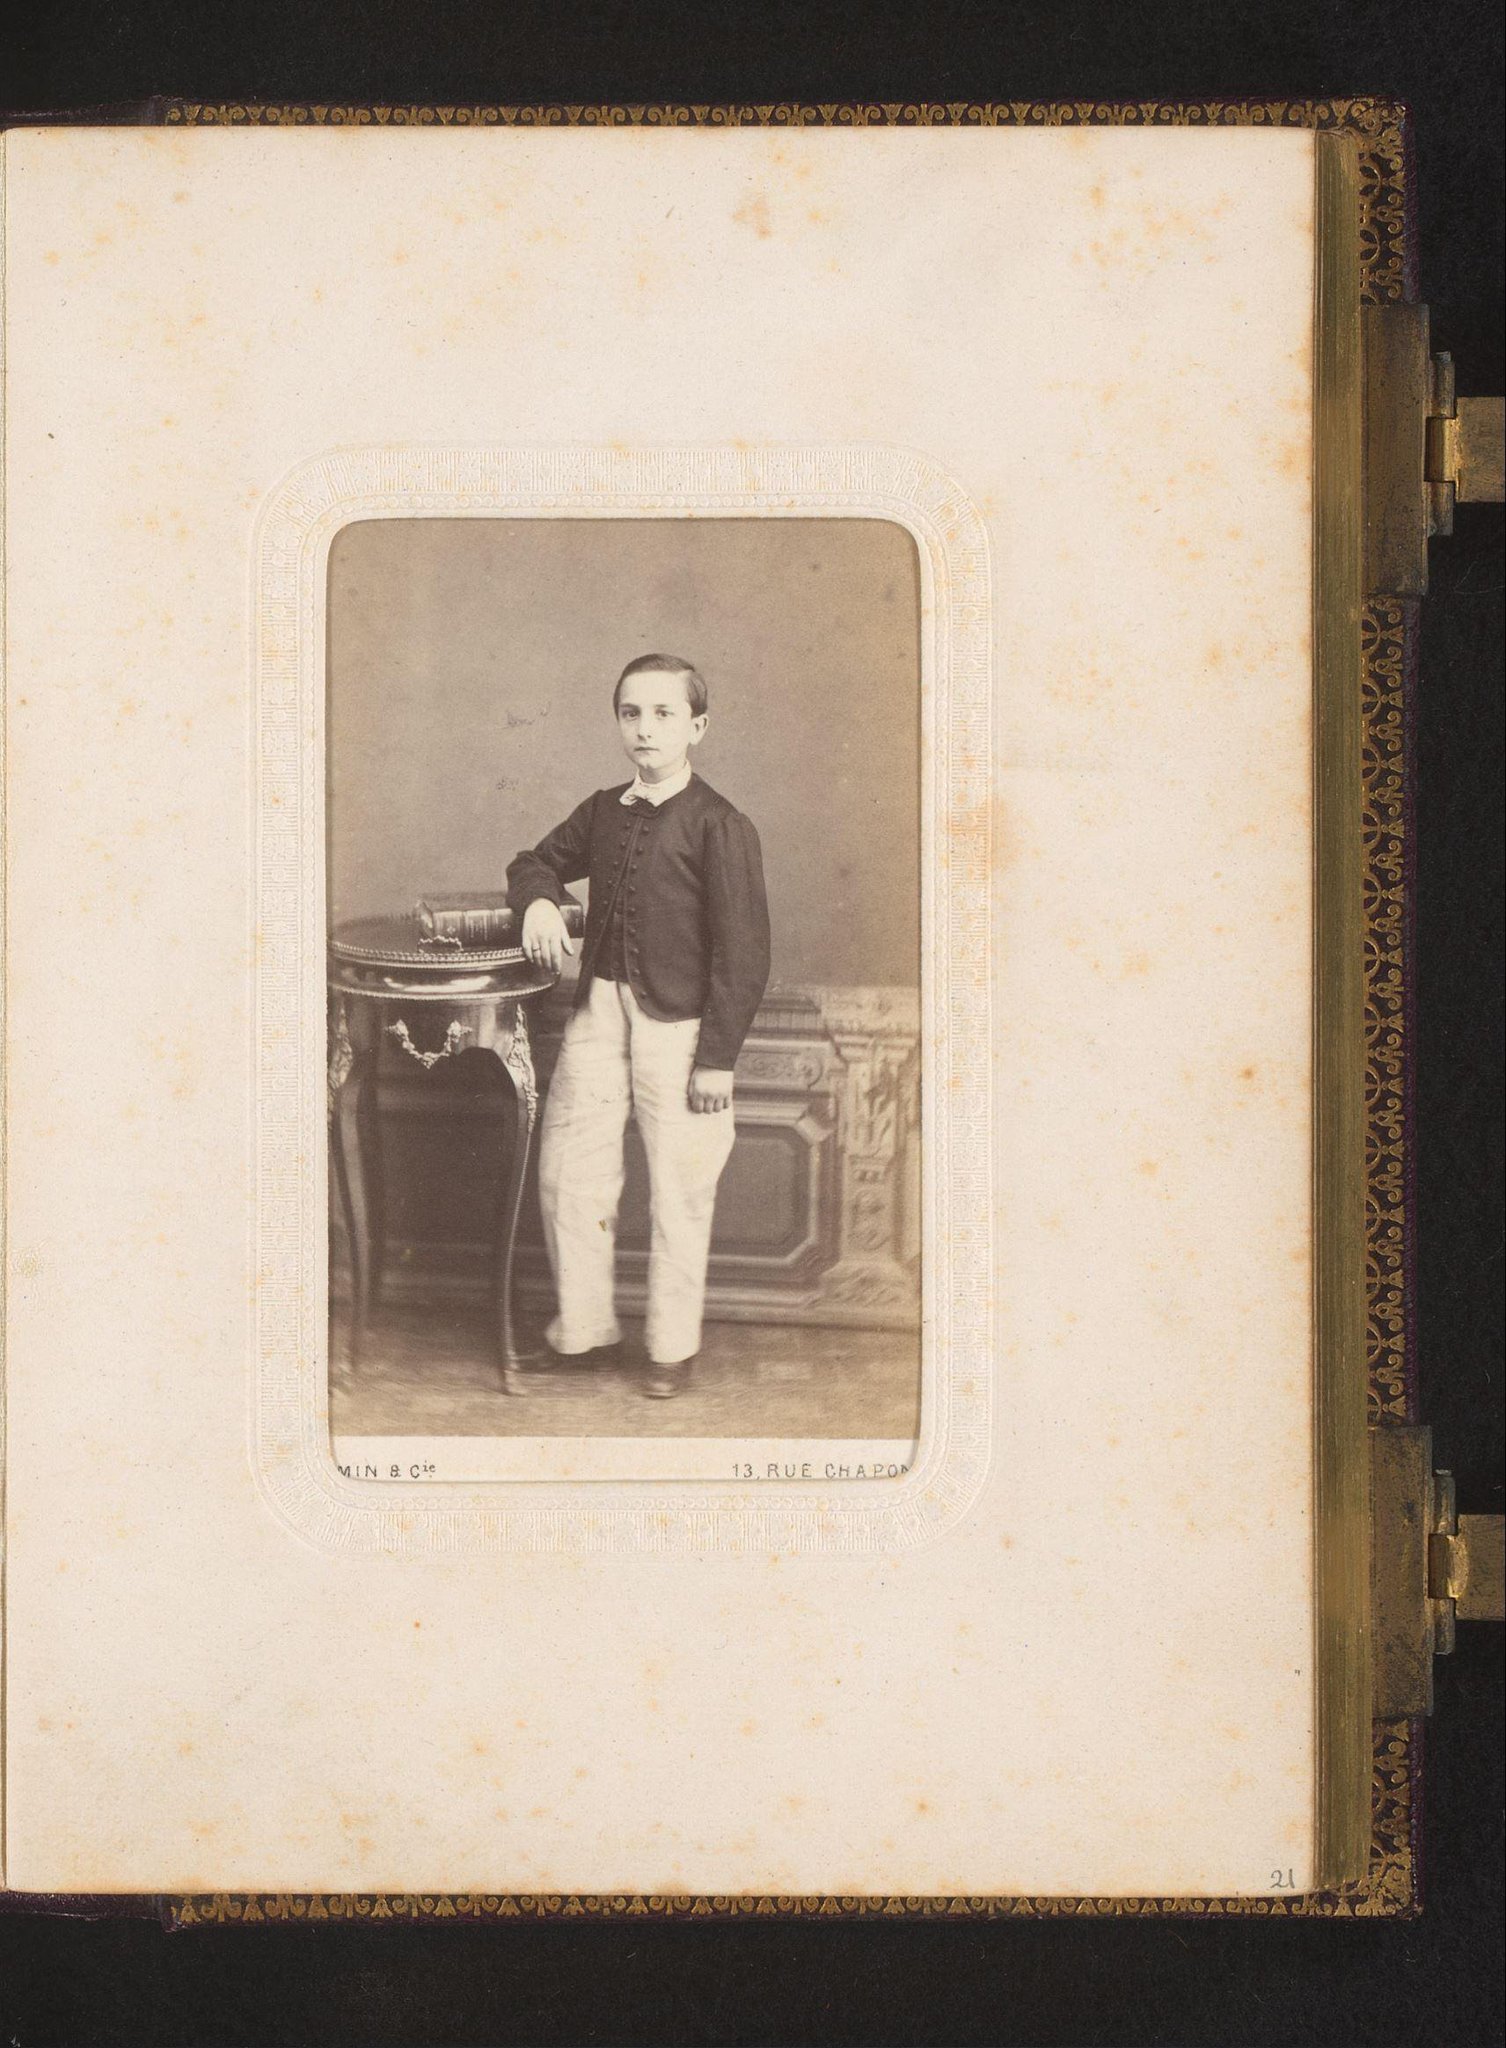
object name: photograph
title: Portret van een jongen, staand bij een tafel met een boek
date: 1860-1900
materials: cardboard, photographic support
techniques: albumen print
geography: paris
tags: boy (child between toddler and youth), historical persons, table, book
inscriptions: inscription: ‘PHOTOGRAPHIE/ JAMIN & Cie/ (Btes S.D.G.D.)/ 13, Rue Chapon, 13./ HÔTEL DE MONTBRISON/ Paris.’